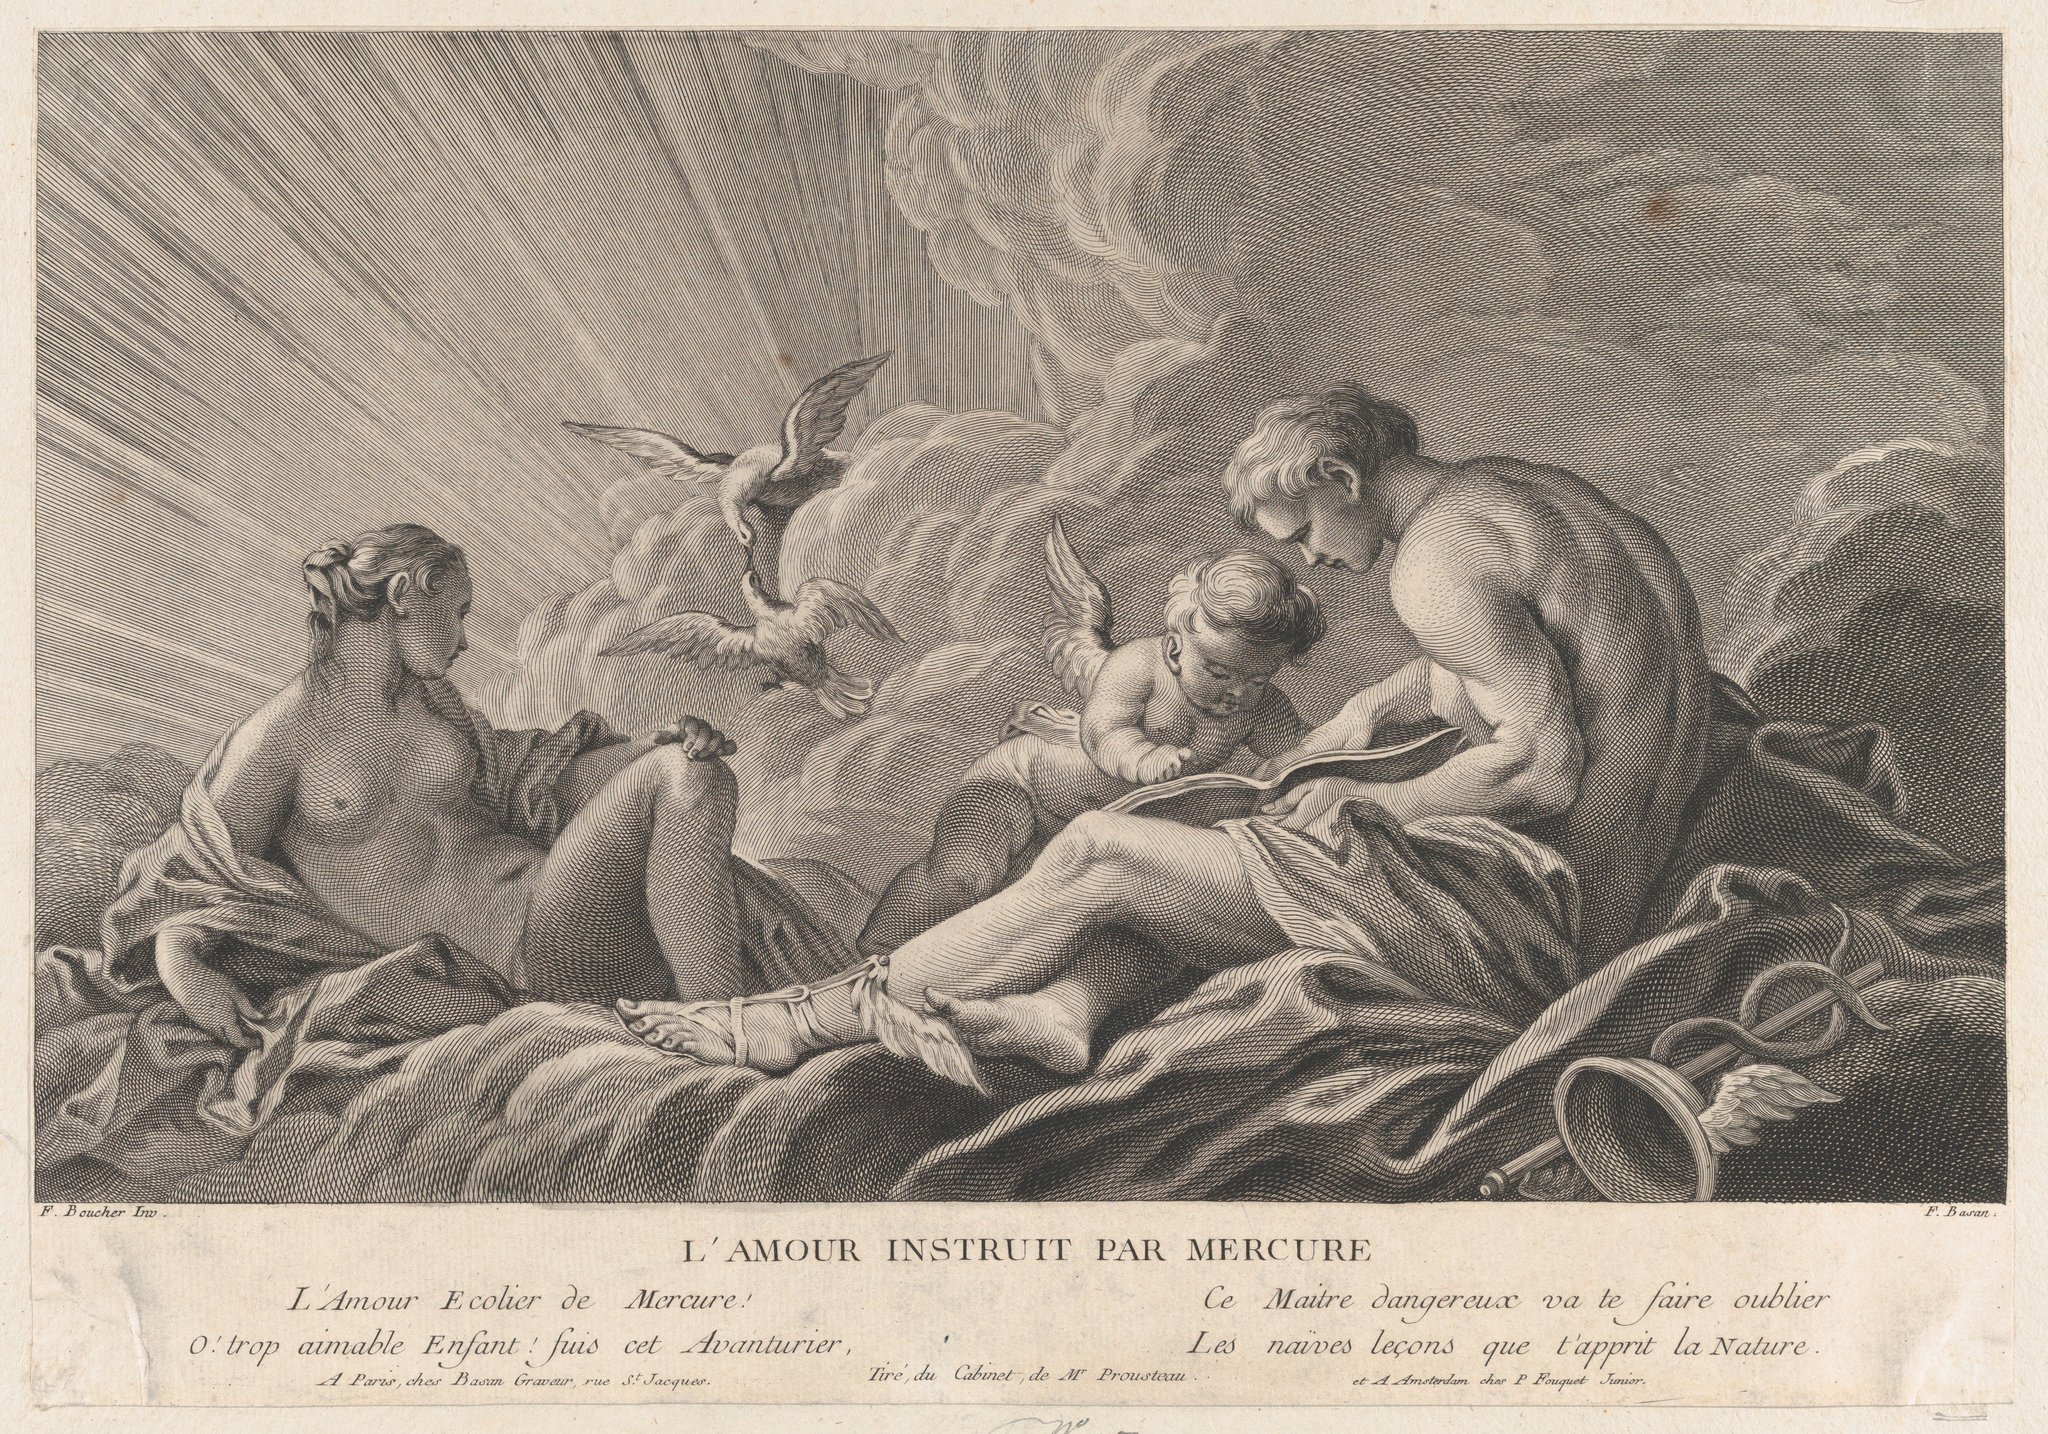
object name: print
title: Love Instructed By Mercury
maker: pierre françois basan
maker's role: artist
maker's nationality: french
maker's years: 1723-1797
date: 1701-1800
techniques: engraving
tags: birds,mercury,venus